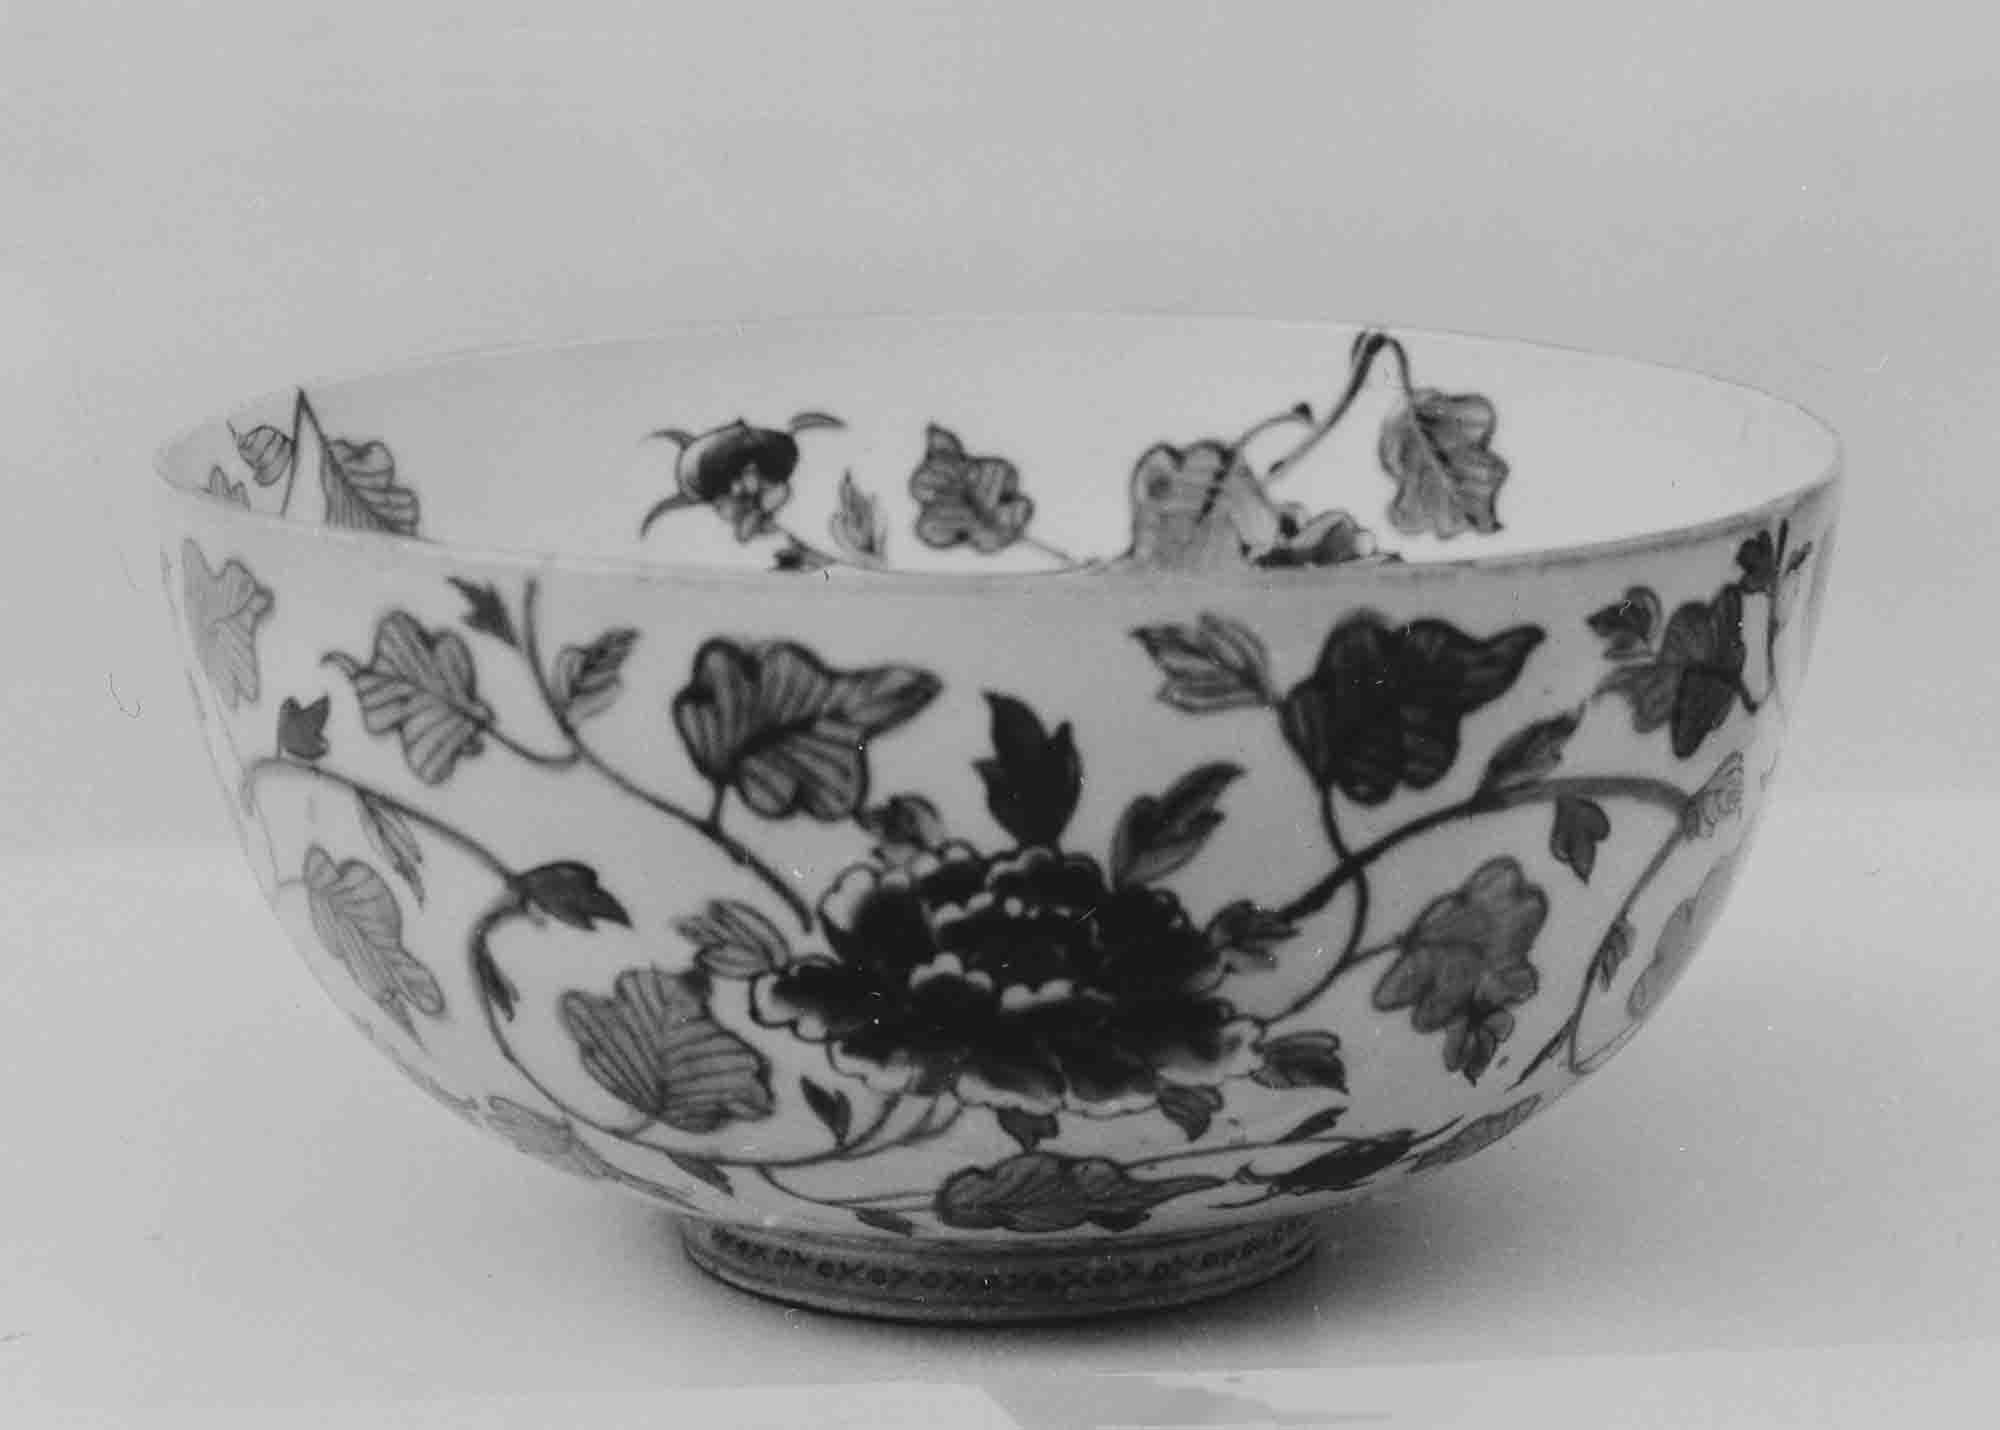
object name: bowl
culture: japanese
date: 1780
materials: enamel, porcelain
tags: flowers,leaves